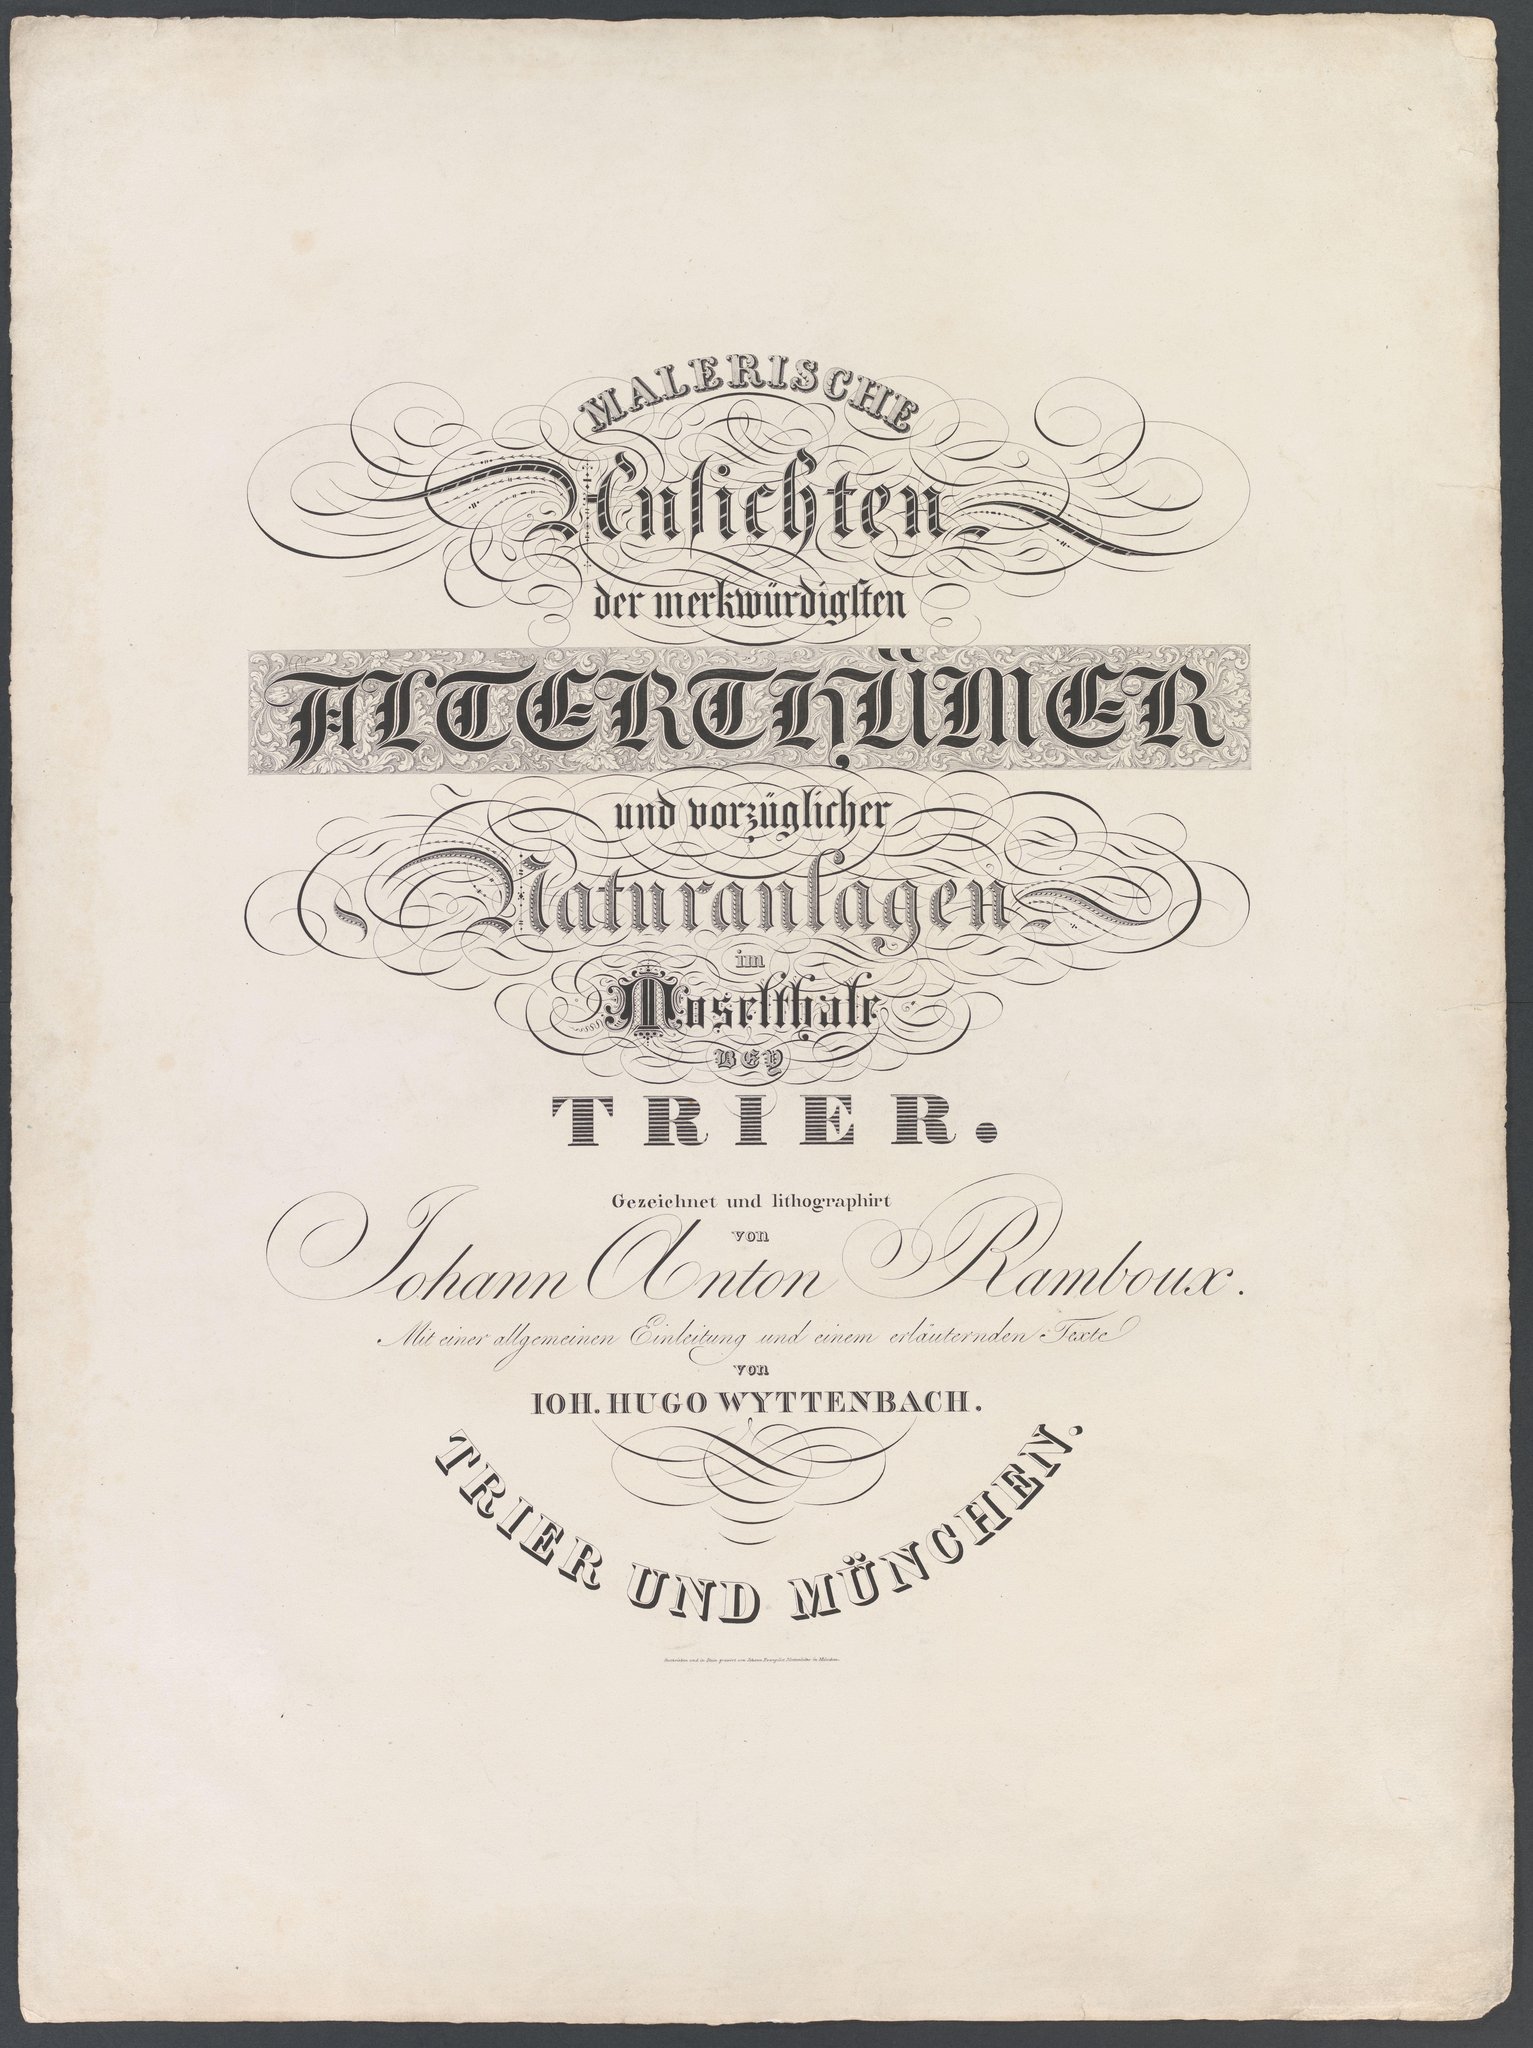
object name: titelprent, frontispice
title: Titelblad en toelichting bij de reeks Mahlerische Ansichten der merkwürdigsten Alterthümer und vorzüglicher Naturanlagen im Moselthale bey Trier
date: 1827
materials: paper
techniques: letterpress printing, lithograph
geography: munich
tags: trier, mosel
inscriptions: collector's mark: Lugt 2228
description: Titelblad en toelichting van zes bladen met drie illustraties bij de reeks van twaalf Johann Anton Ramboux, Mahlerische Ansichten der merkwürdigsten Alterthümer und vorzüglicher Naturanlagen im Moselthale bey Trier, gepubliceerd in 1824-1827 in Trier en München.